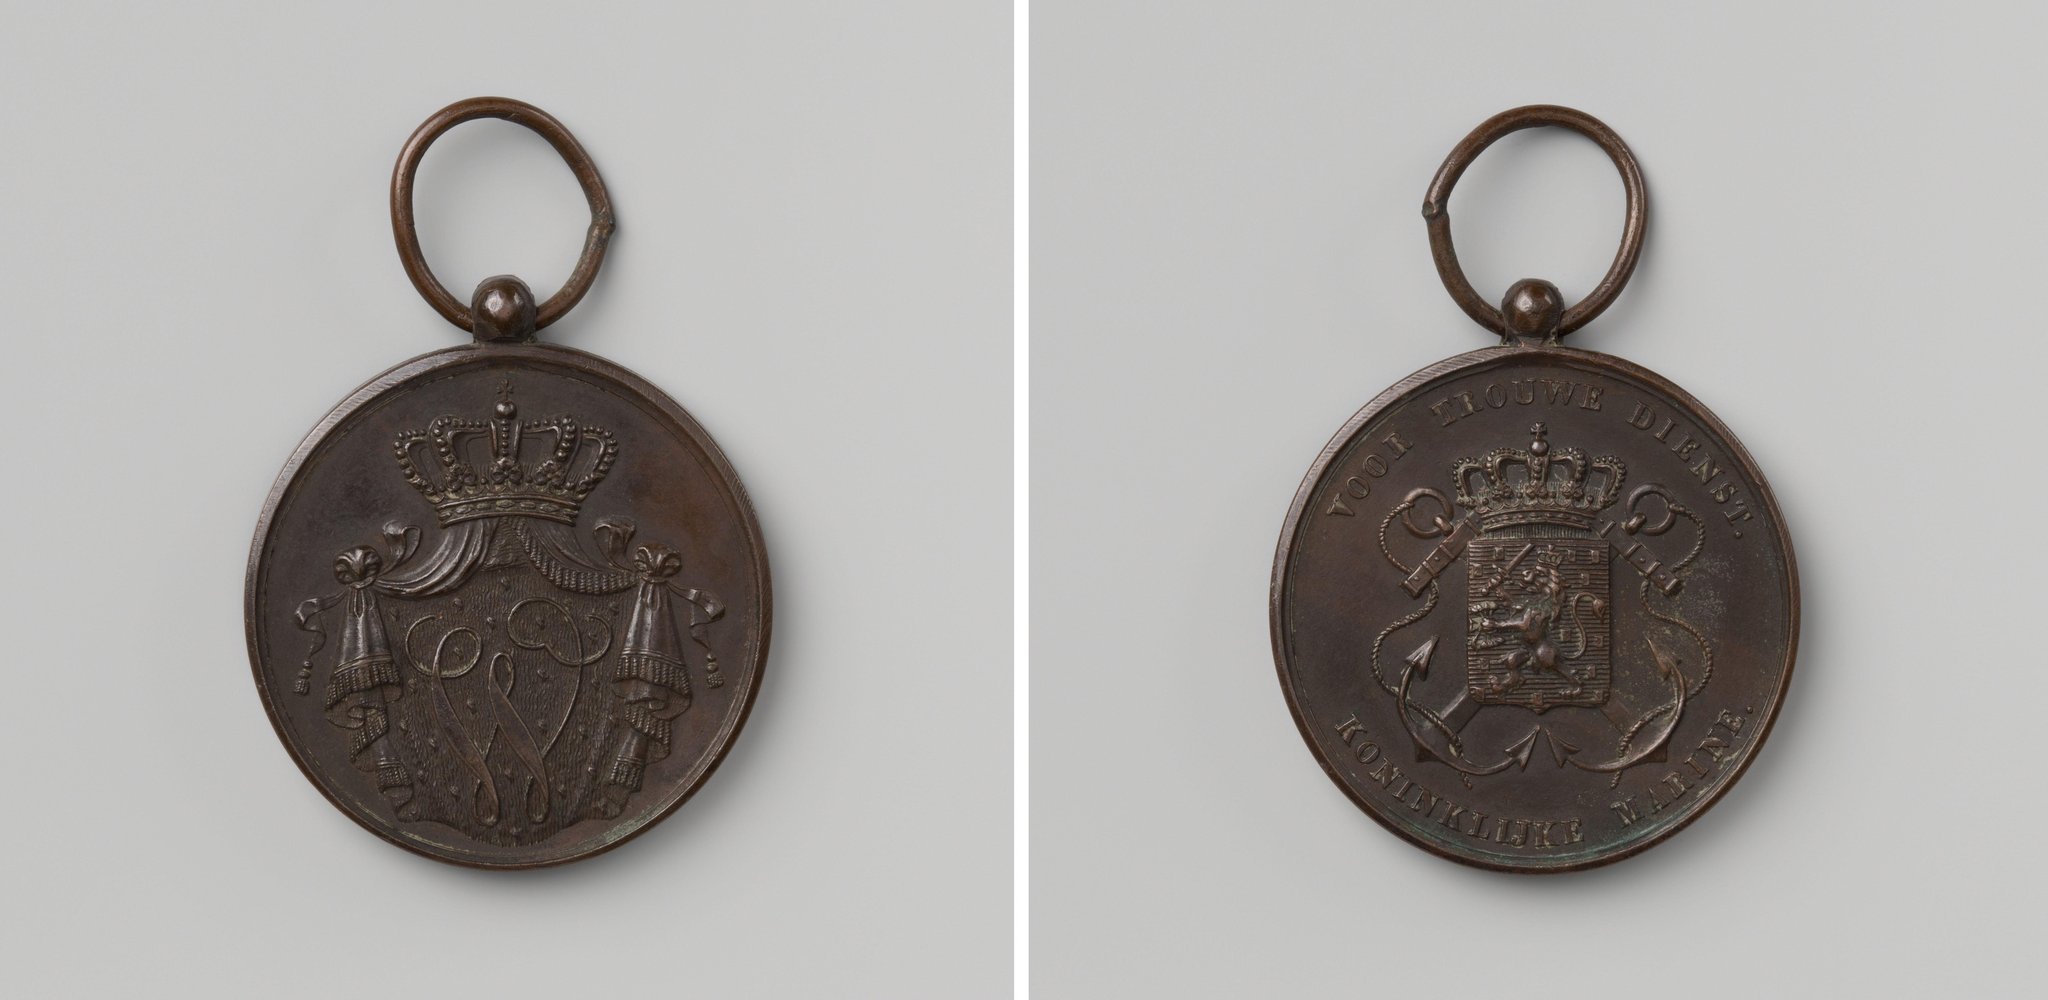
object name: insignia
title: Trouwe dienst bij de marine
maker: Anonymous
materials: bronze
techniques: striking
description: Bronzen draagteken aan draagoog en draagring. Voorzijde: gekroonde hermelijnen mantel; daarop letter W. Keerzijde: gekroond wapenschild op twee gekruiste ankers binnen omschrift.